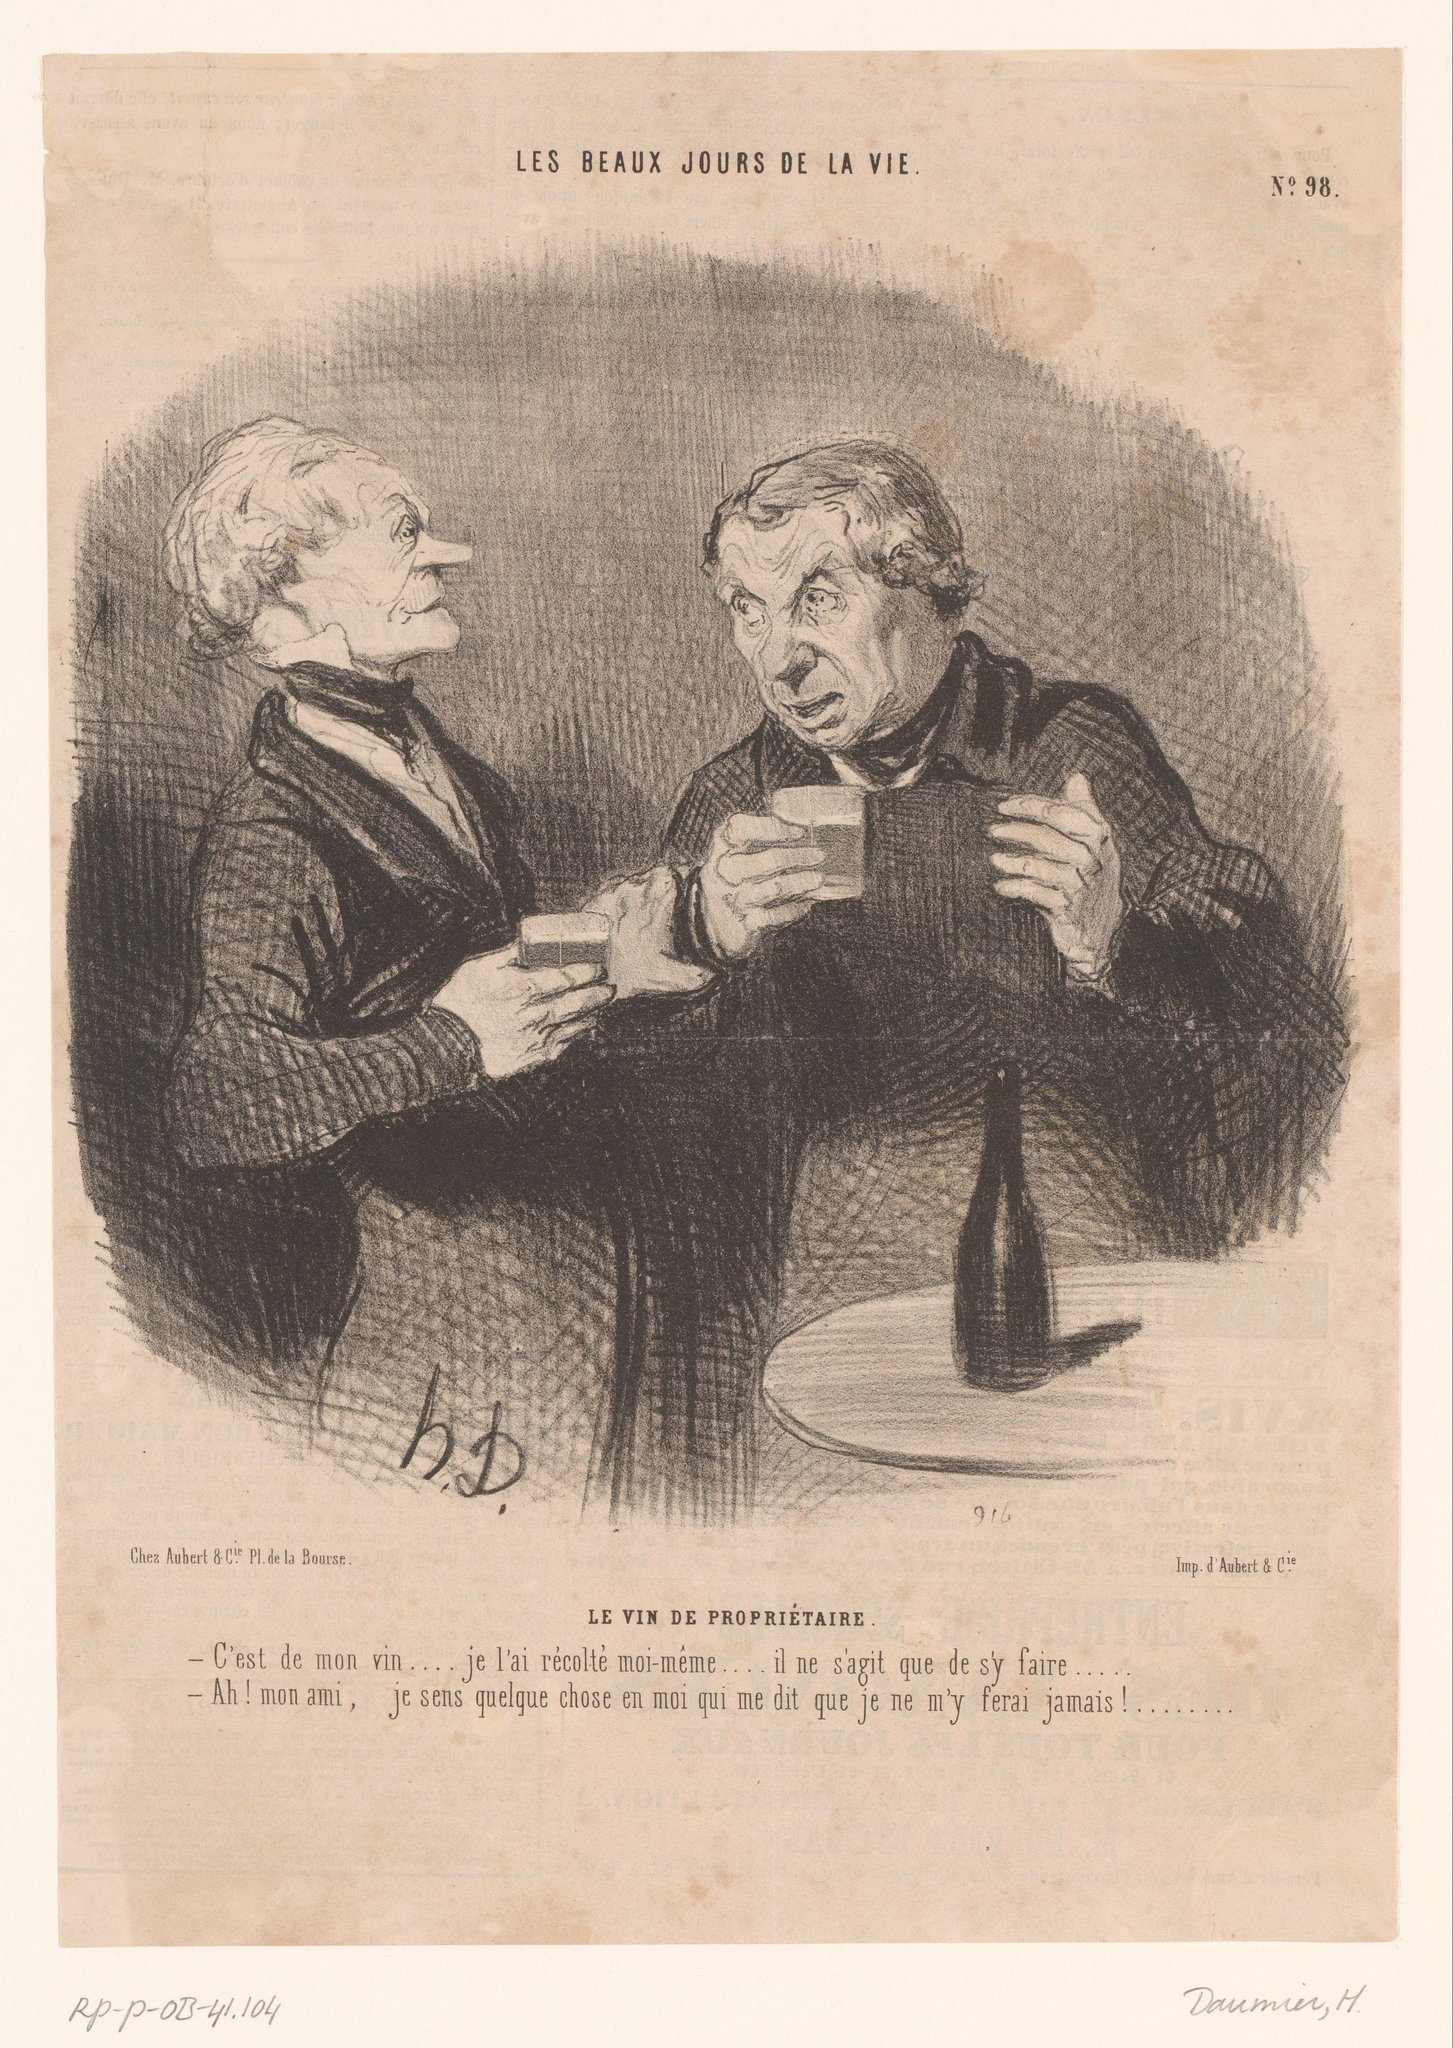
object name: cartoon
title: Le vin de propriétaire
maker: honoré daumier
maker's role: draughtsman, painter, print maker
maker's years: 1808-1879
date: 1846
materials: paper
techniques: lithograph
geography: paris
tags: caricatures (human types), wine ~ alcoholic drinks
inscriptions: collector's mark: Lugt 2228a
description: De ene man vertelt aan de andere man dat hij de wijn zelf geoogst heeft.